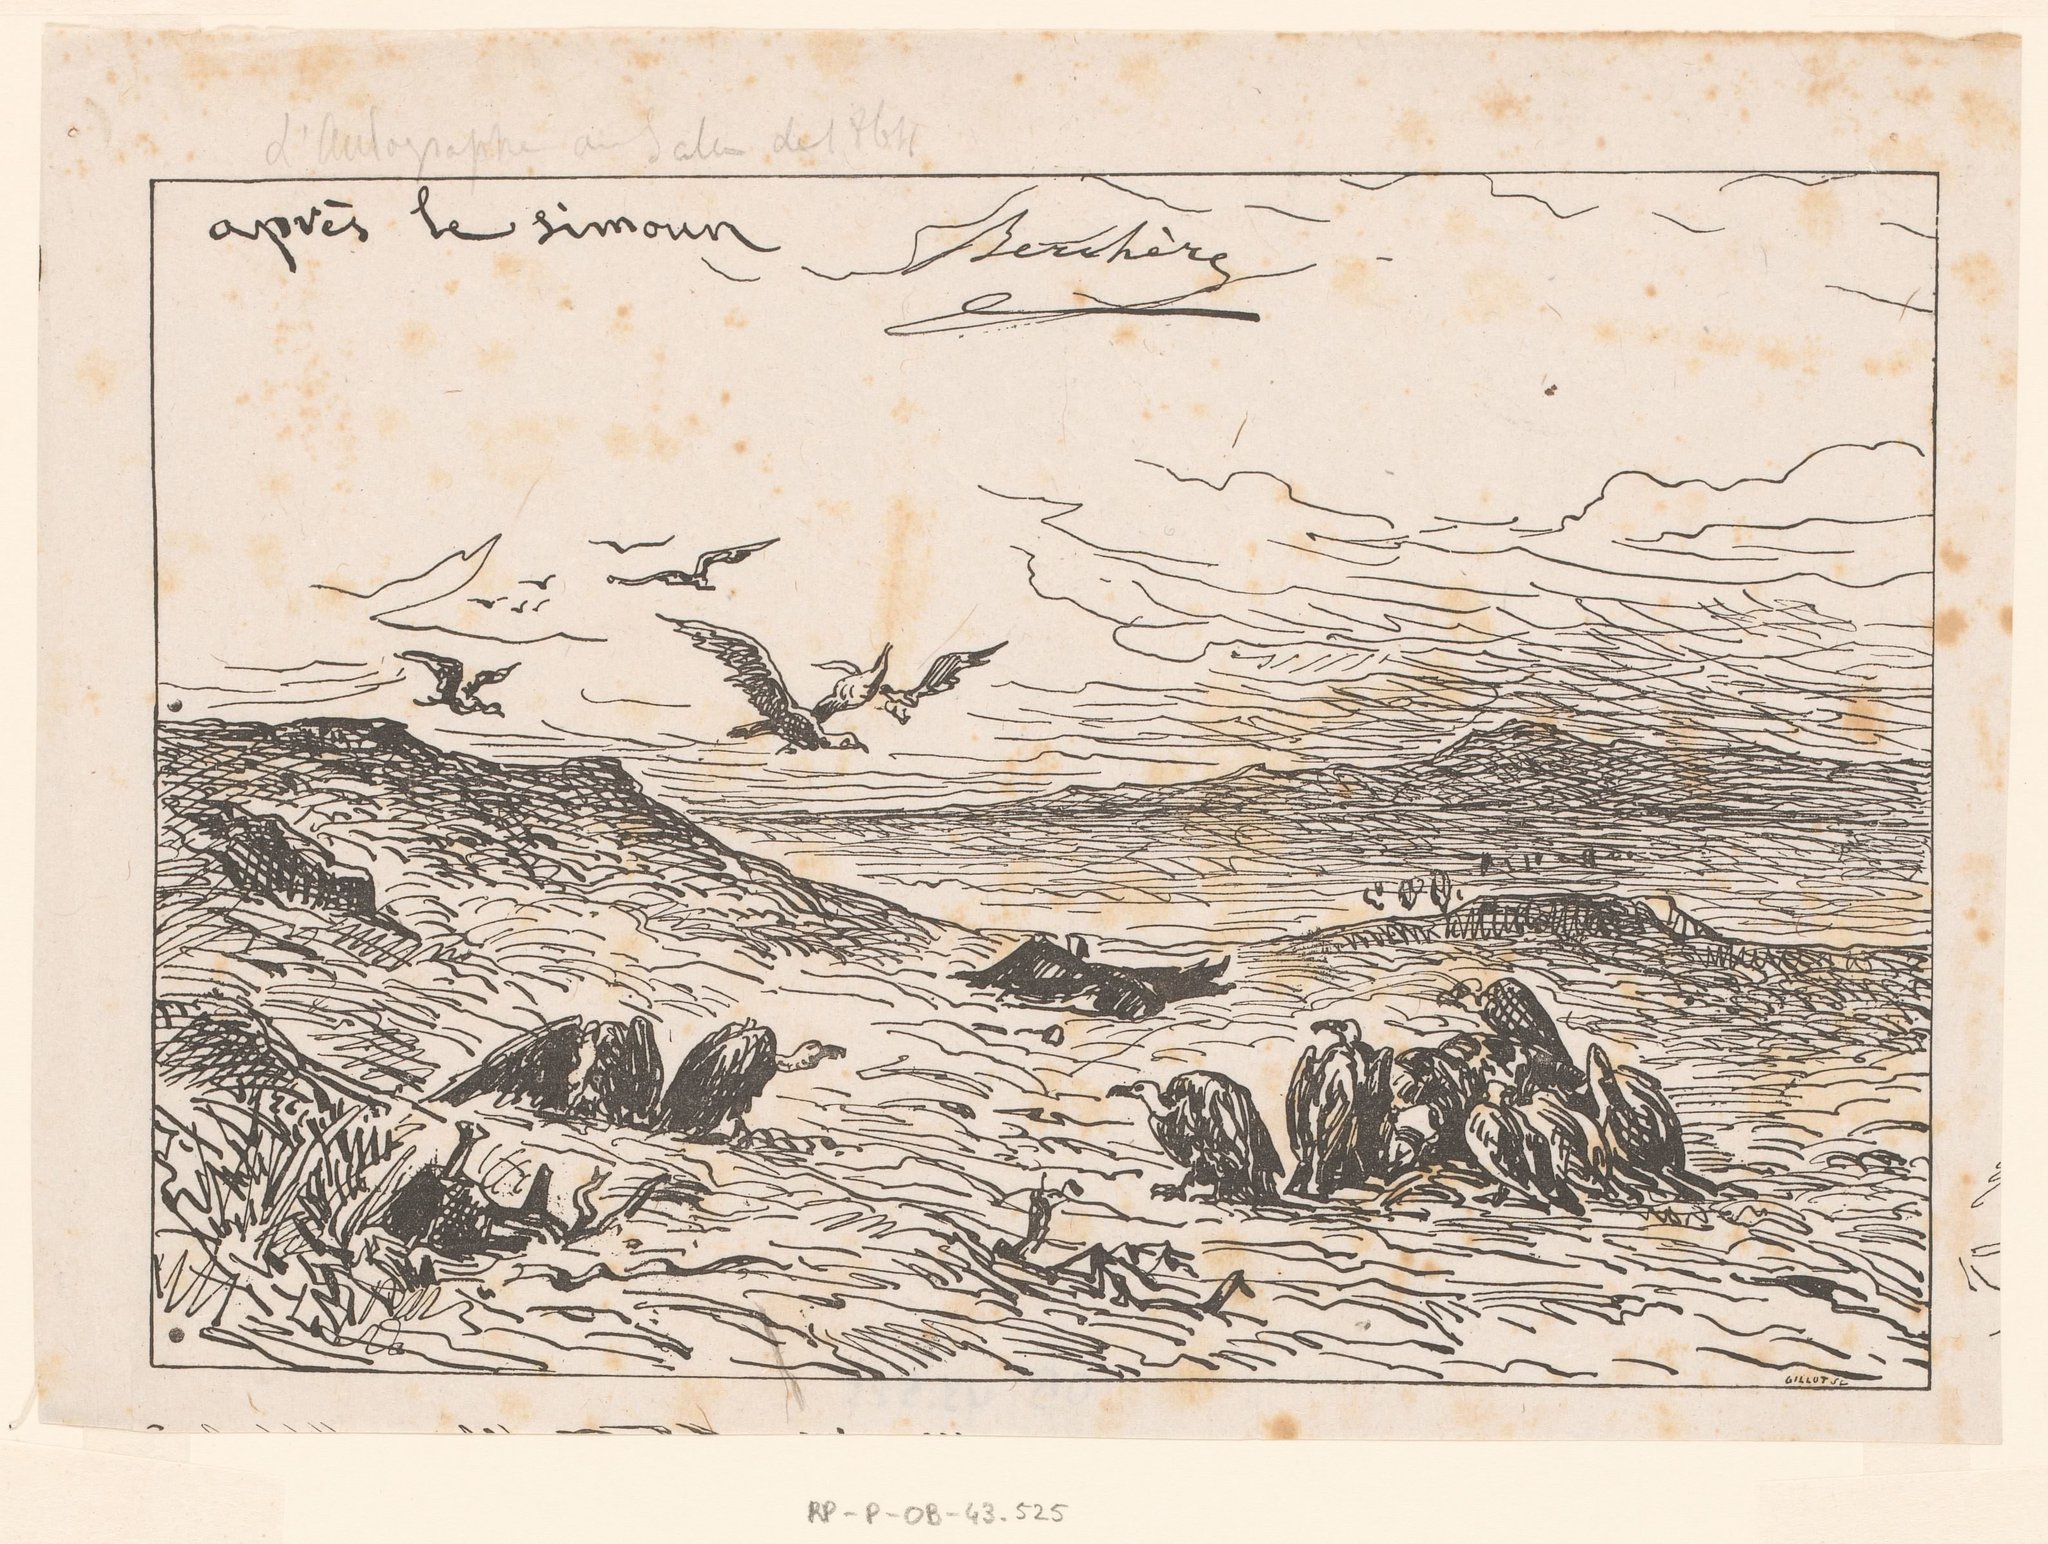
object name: print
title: Landschap met gieren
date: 1864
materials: paper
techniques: gillotage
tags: predatory birds: vulture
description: Prent uit deel twee van het tijdschrift getiteld 'L'Autographe au Salon de 1864 et dans les Ateliers', met voorstellingen door verschillende kunstenaars en hun handtekeningen, bestaande uit acht pagina's.